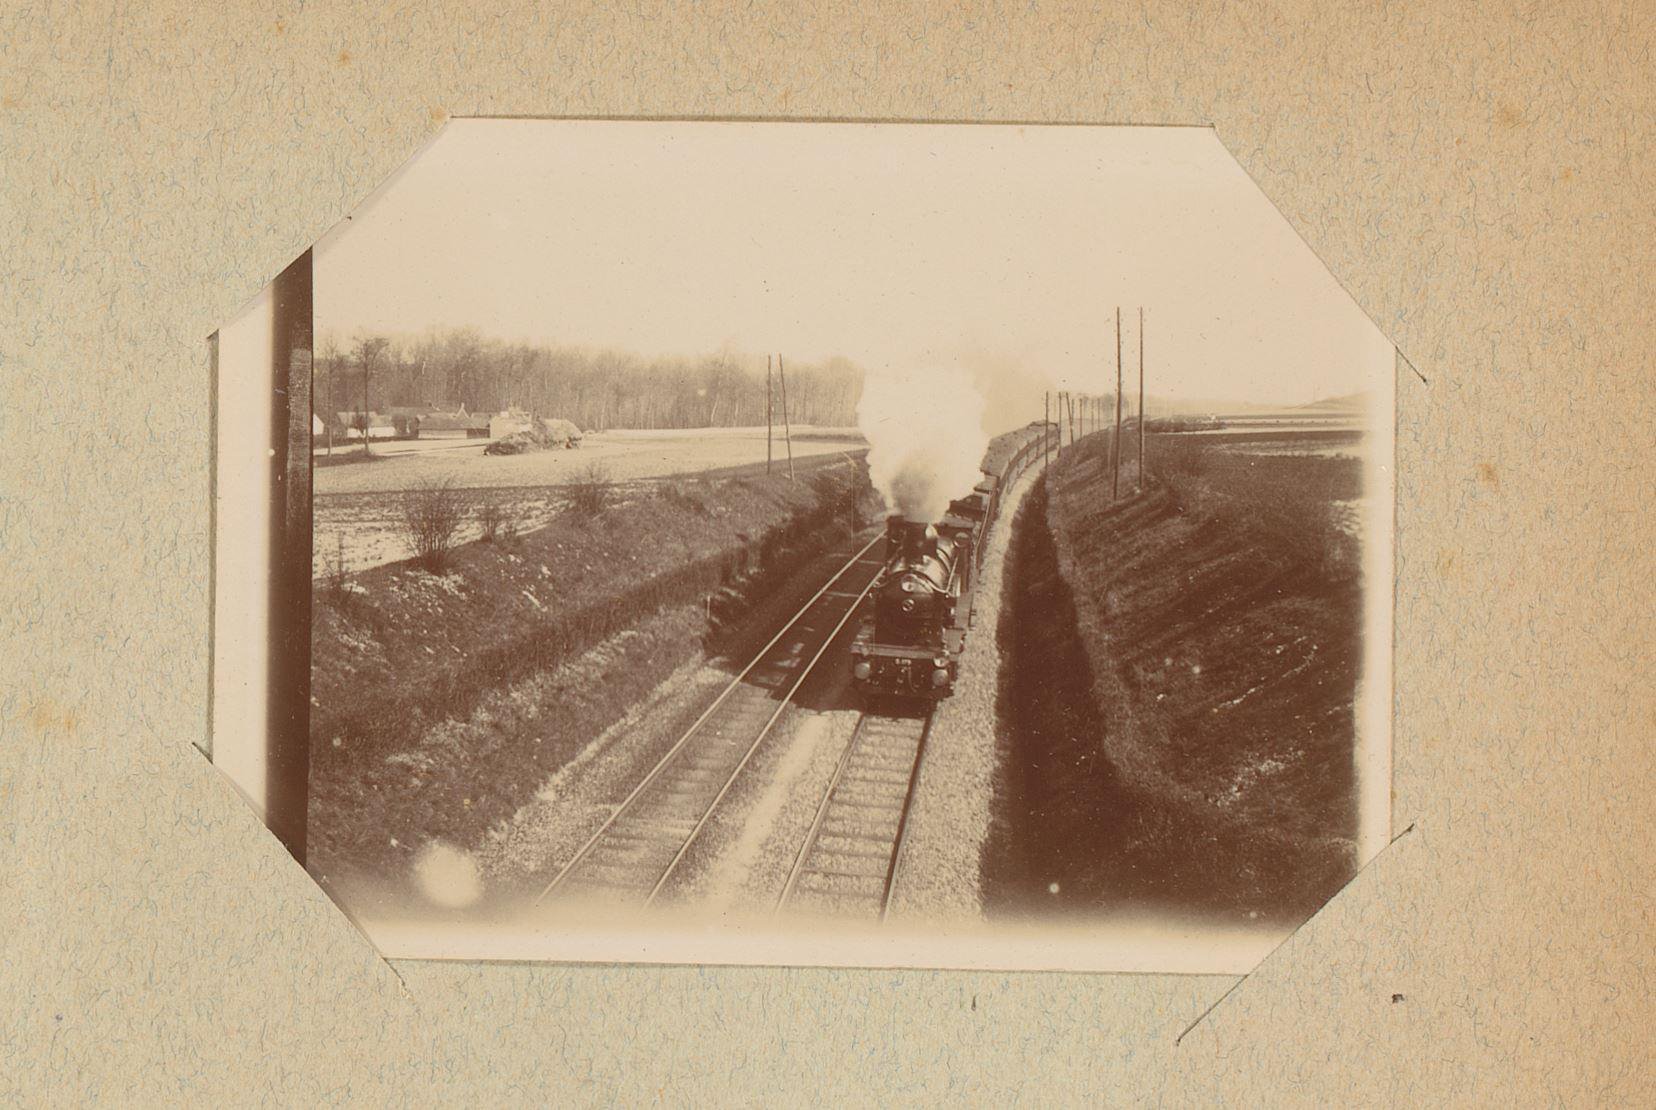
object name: album leaf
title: Stoomtrein gezien van bovenaf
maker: Anonymous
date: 1897-1900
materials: paper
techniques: gelatin silver print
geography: france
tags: railway, train, steam locomotive, france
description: Over de foto is een ander negatief afgedrukt van een voorstelling van bomen.